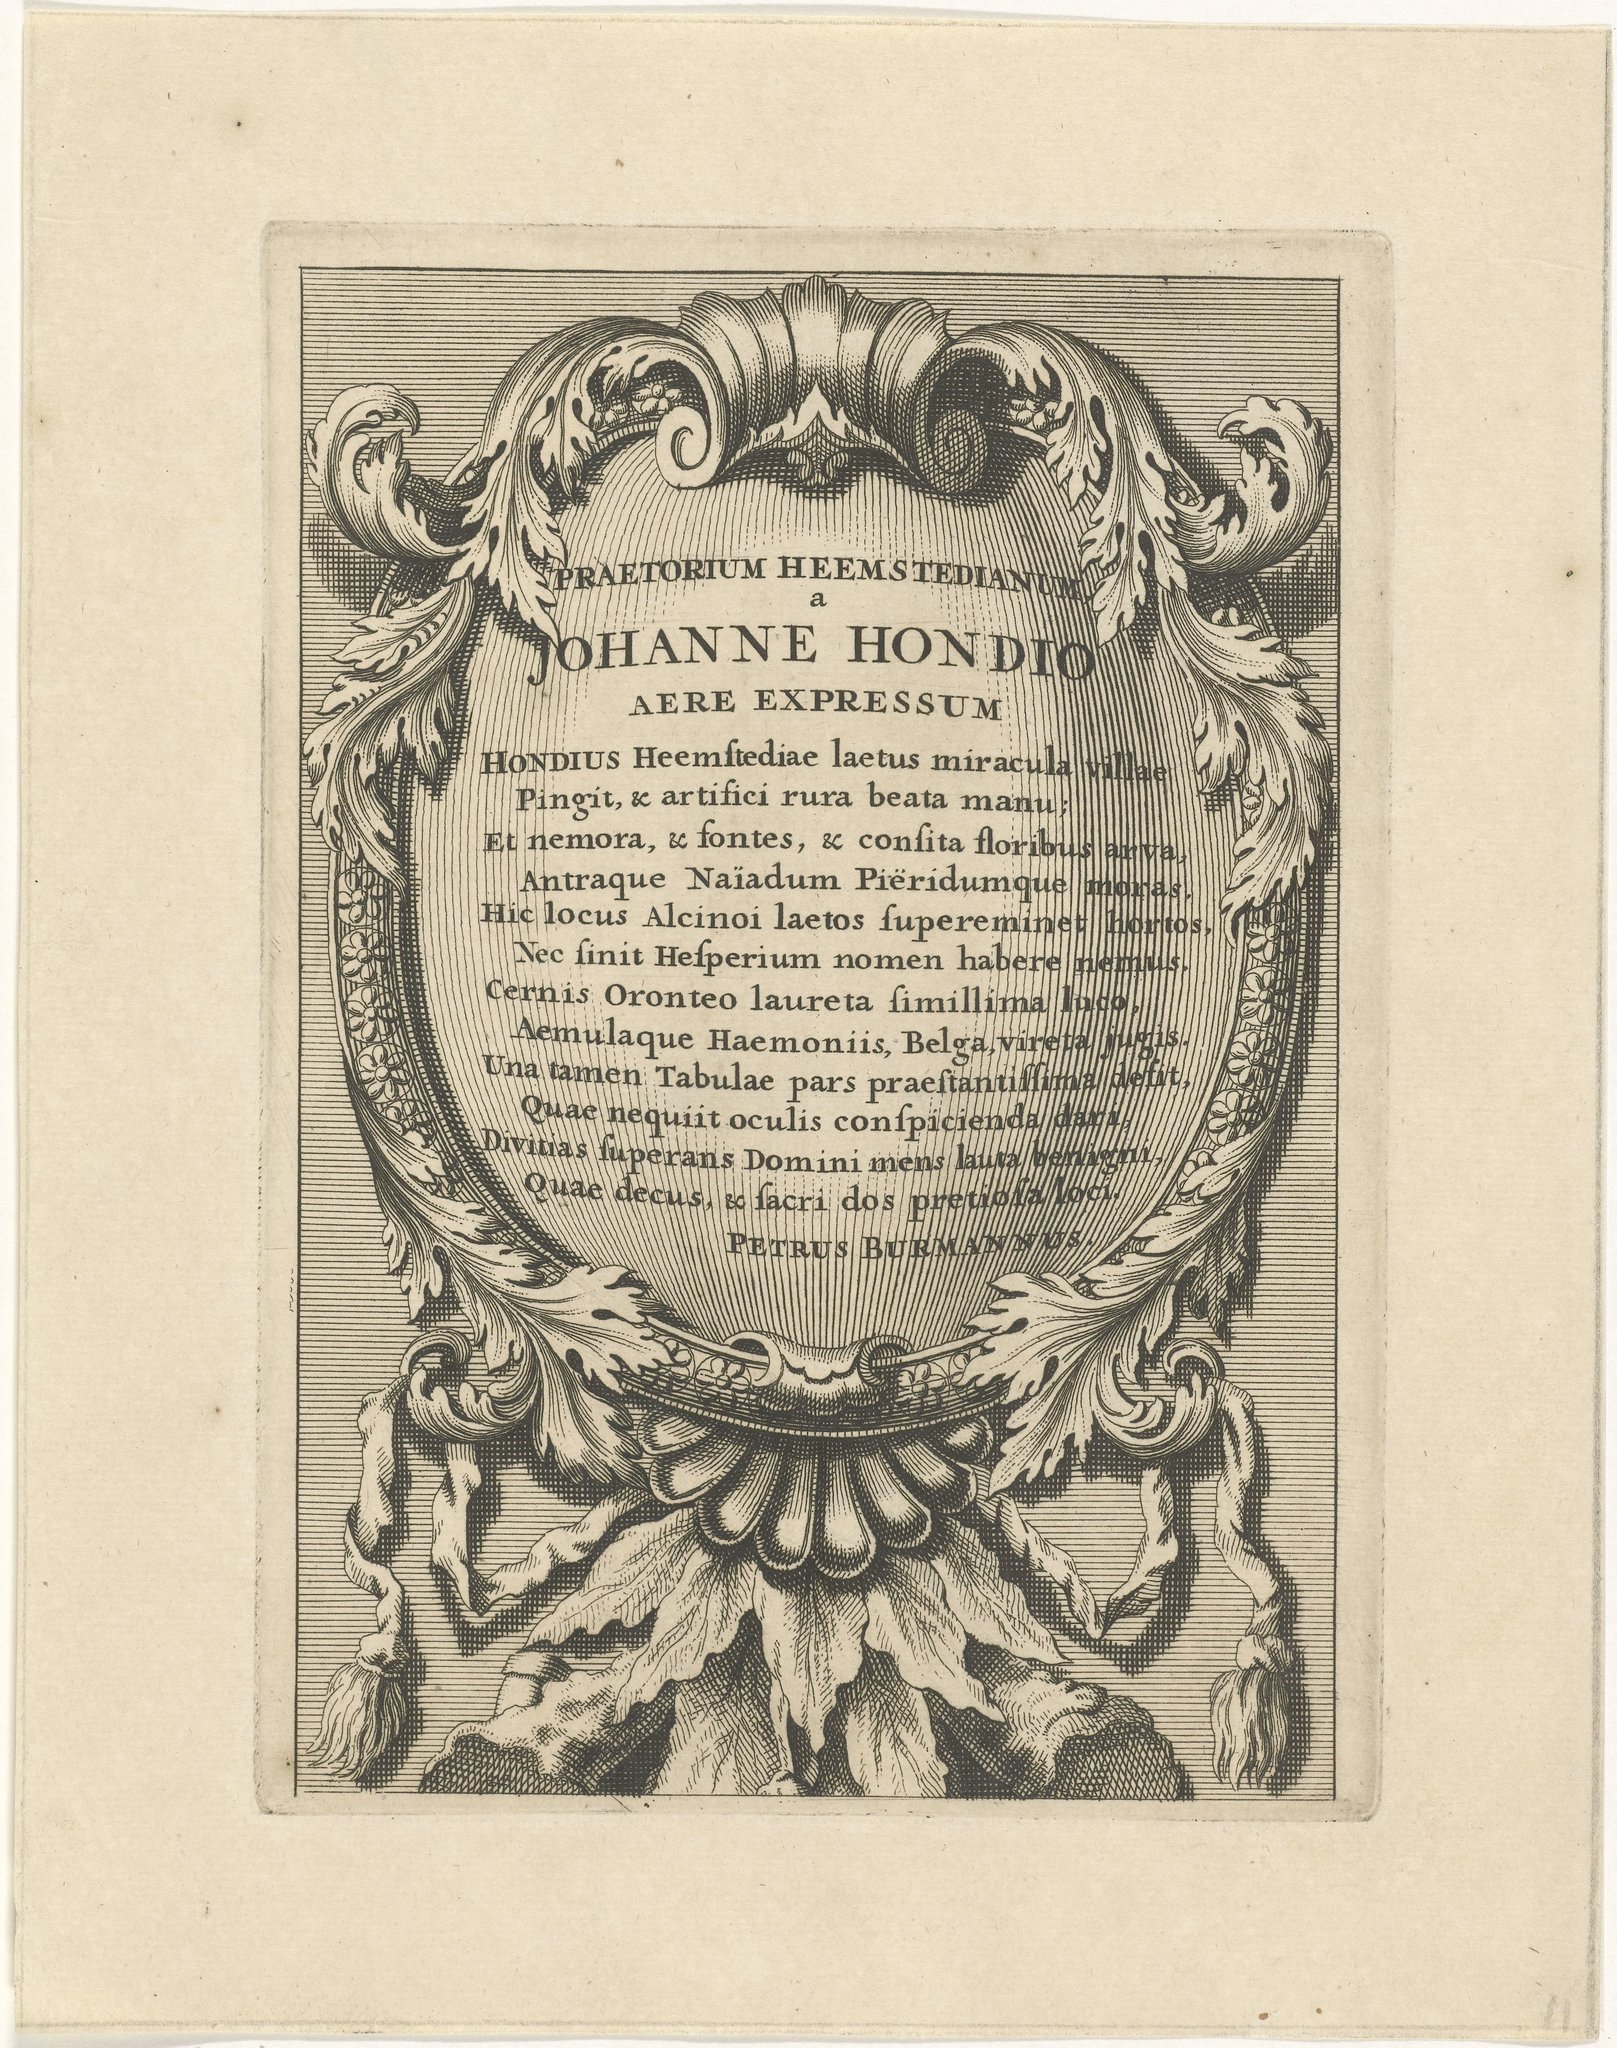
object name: print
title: Cartouche met Latijnse tekst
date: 1700-1799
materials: paper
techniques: engraving, etching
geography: low countries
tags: ornament ~ cartouche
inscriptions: collector's mark: Lugt 2228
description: Een versierd cartouche met een twaalfregelig Latijnse tekst van Petrus Burmannus.